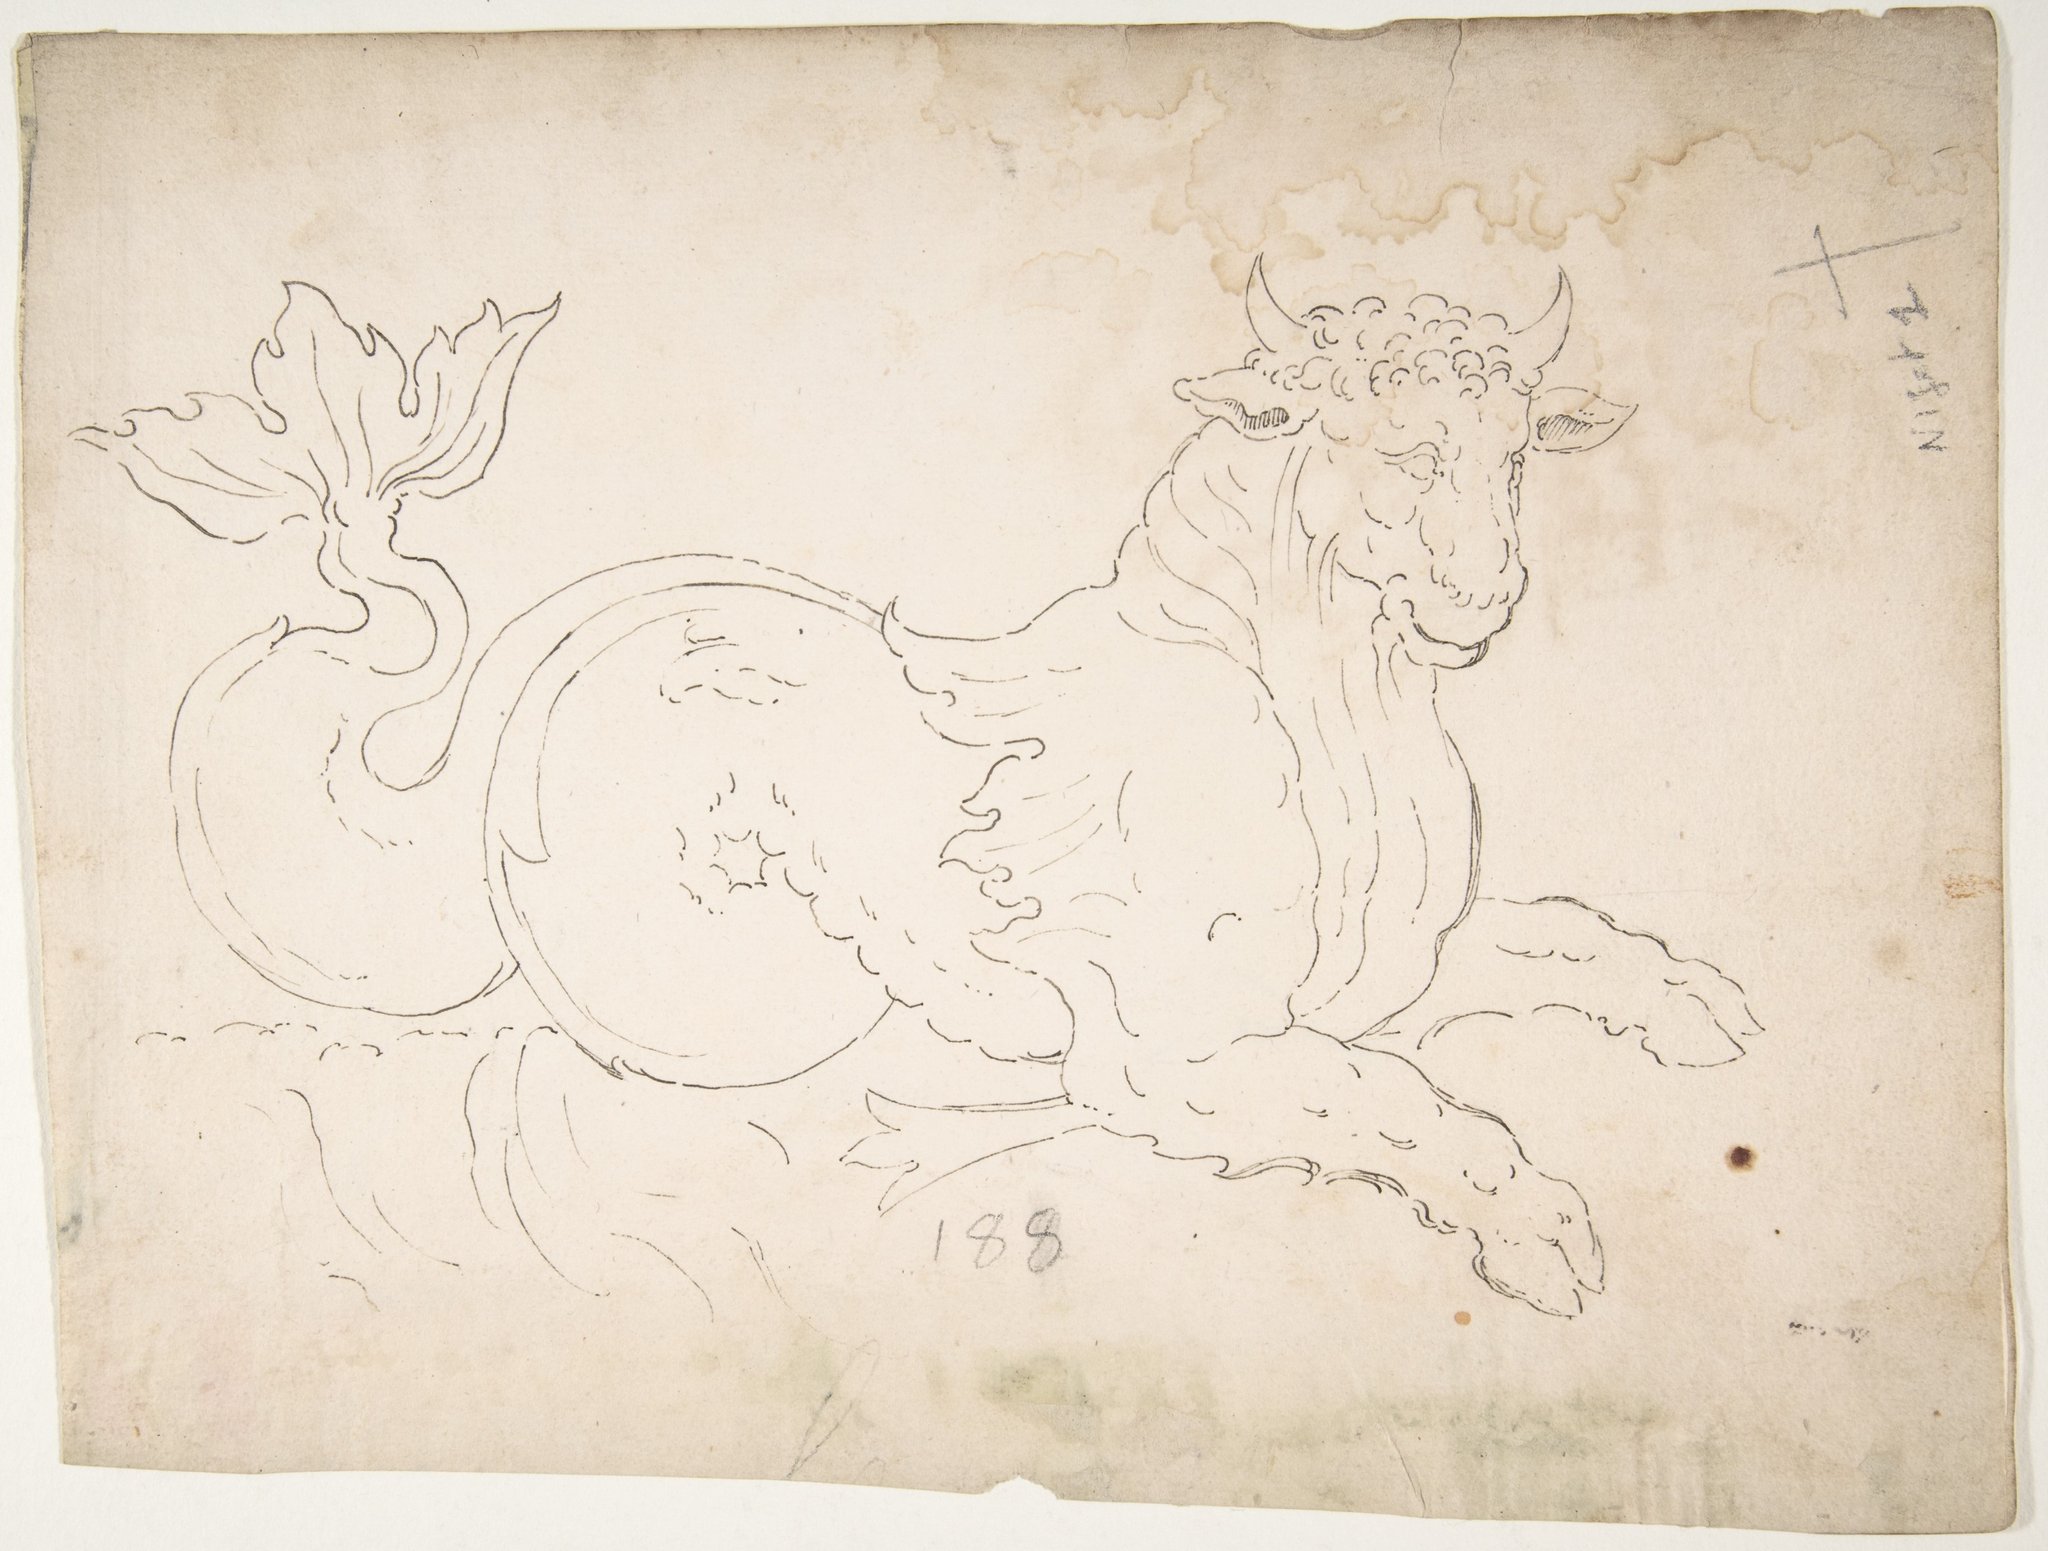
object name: collection ornament architecture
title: Marine bull, detail (recto) blank (verso)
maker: anonymous, french, 16th century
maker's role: draftsman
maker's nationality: french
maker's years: 1500-1600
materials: chalk, ink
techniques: incising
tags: bulls